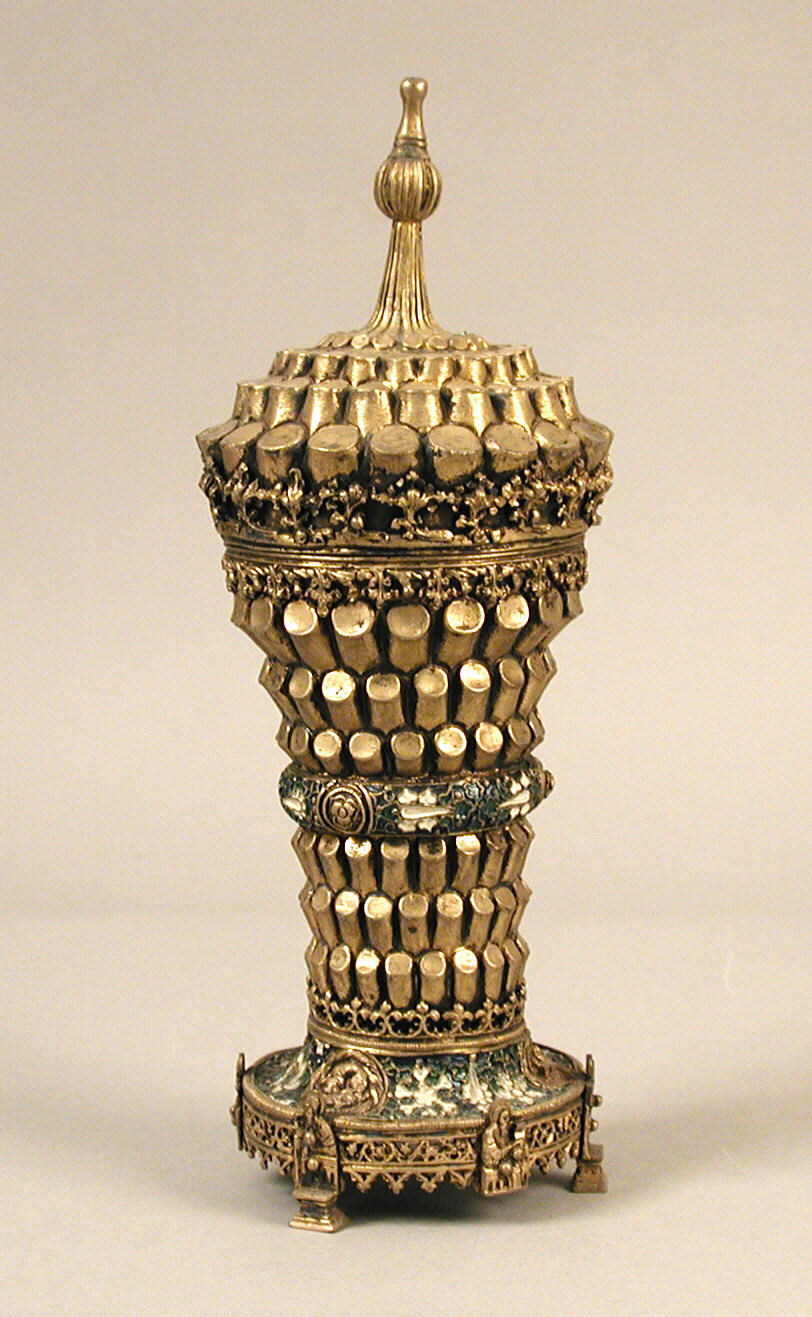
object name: beaker with cover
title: Beaker and Cover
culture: hungarian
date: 1901-1933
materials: silver gilt